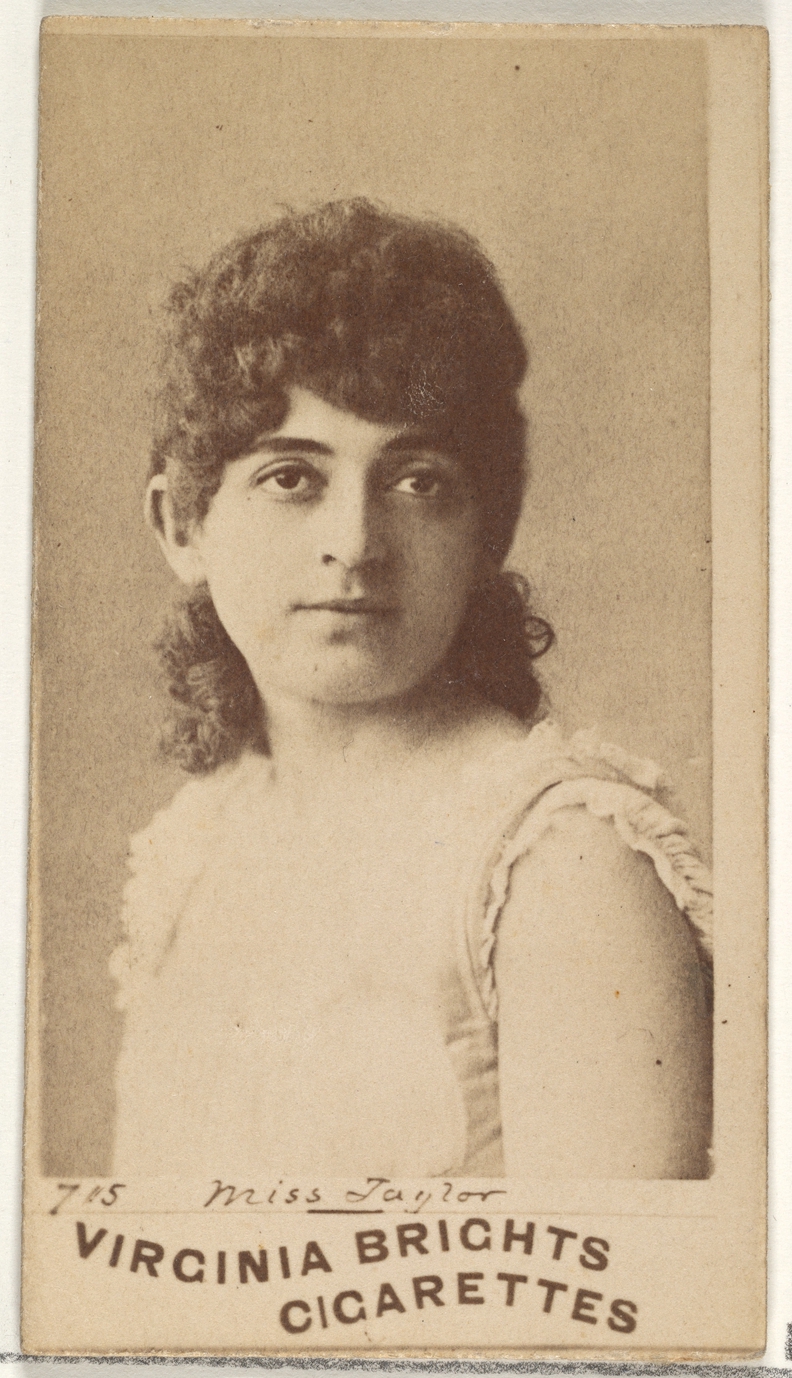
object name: photograph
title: Card 715, Miss Taylor, from the Actors and Actresses series (N45, Type 1) for Virginia Brights Cigarettes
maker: allen & ginter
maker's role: publisher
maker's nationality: american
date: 1888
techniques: albumen silver print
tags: portraits,women,actresses